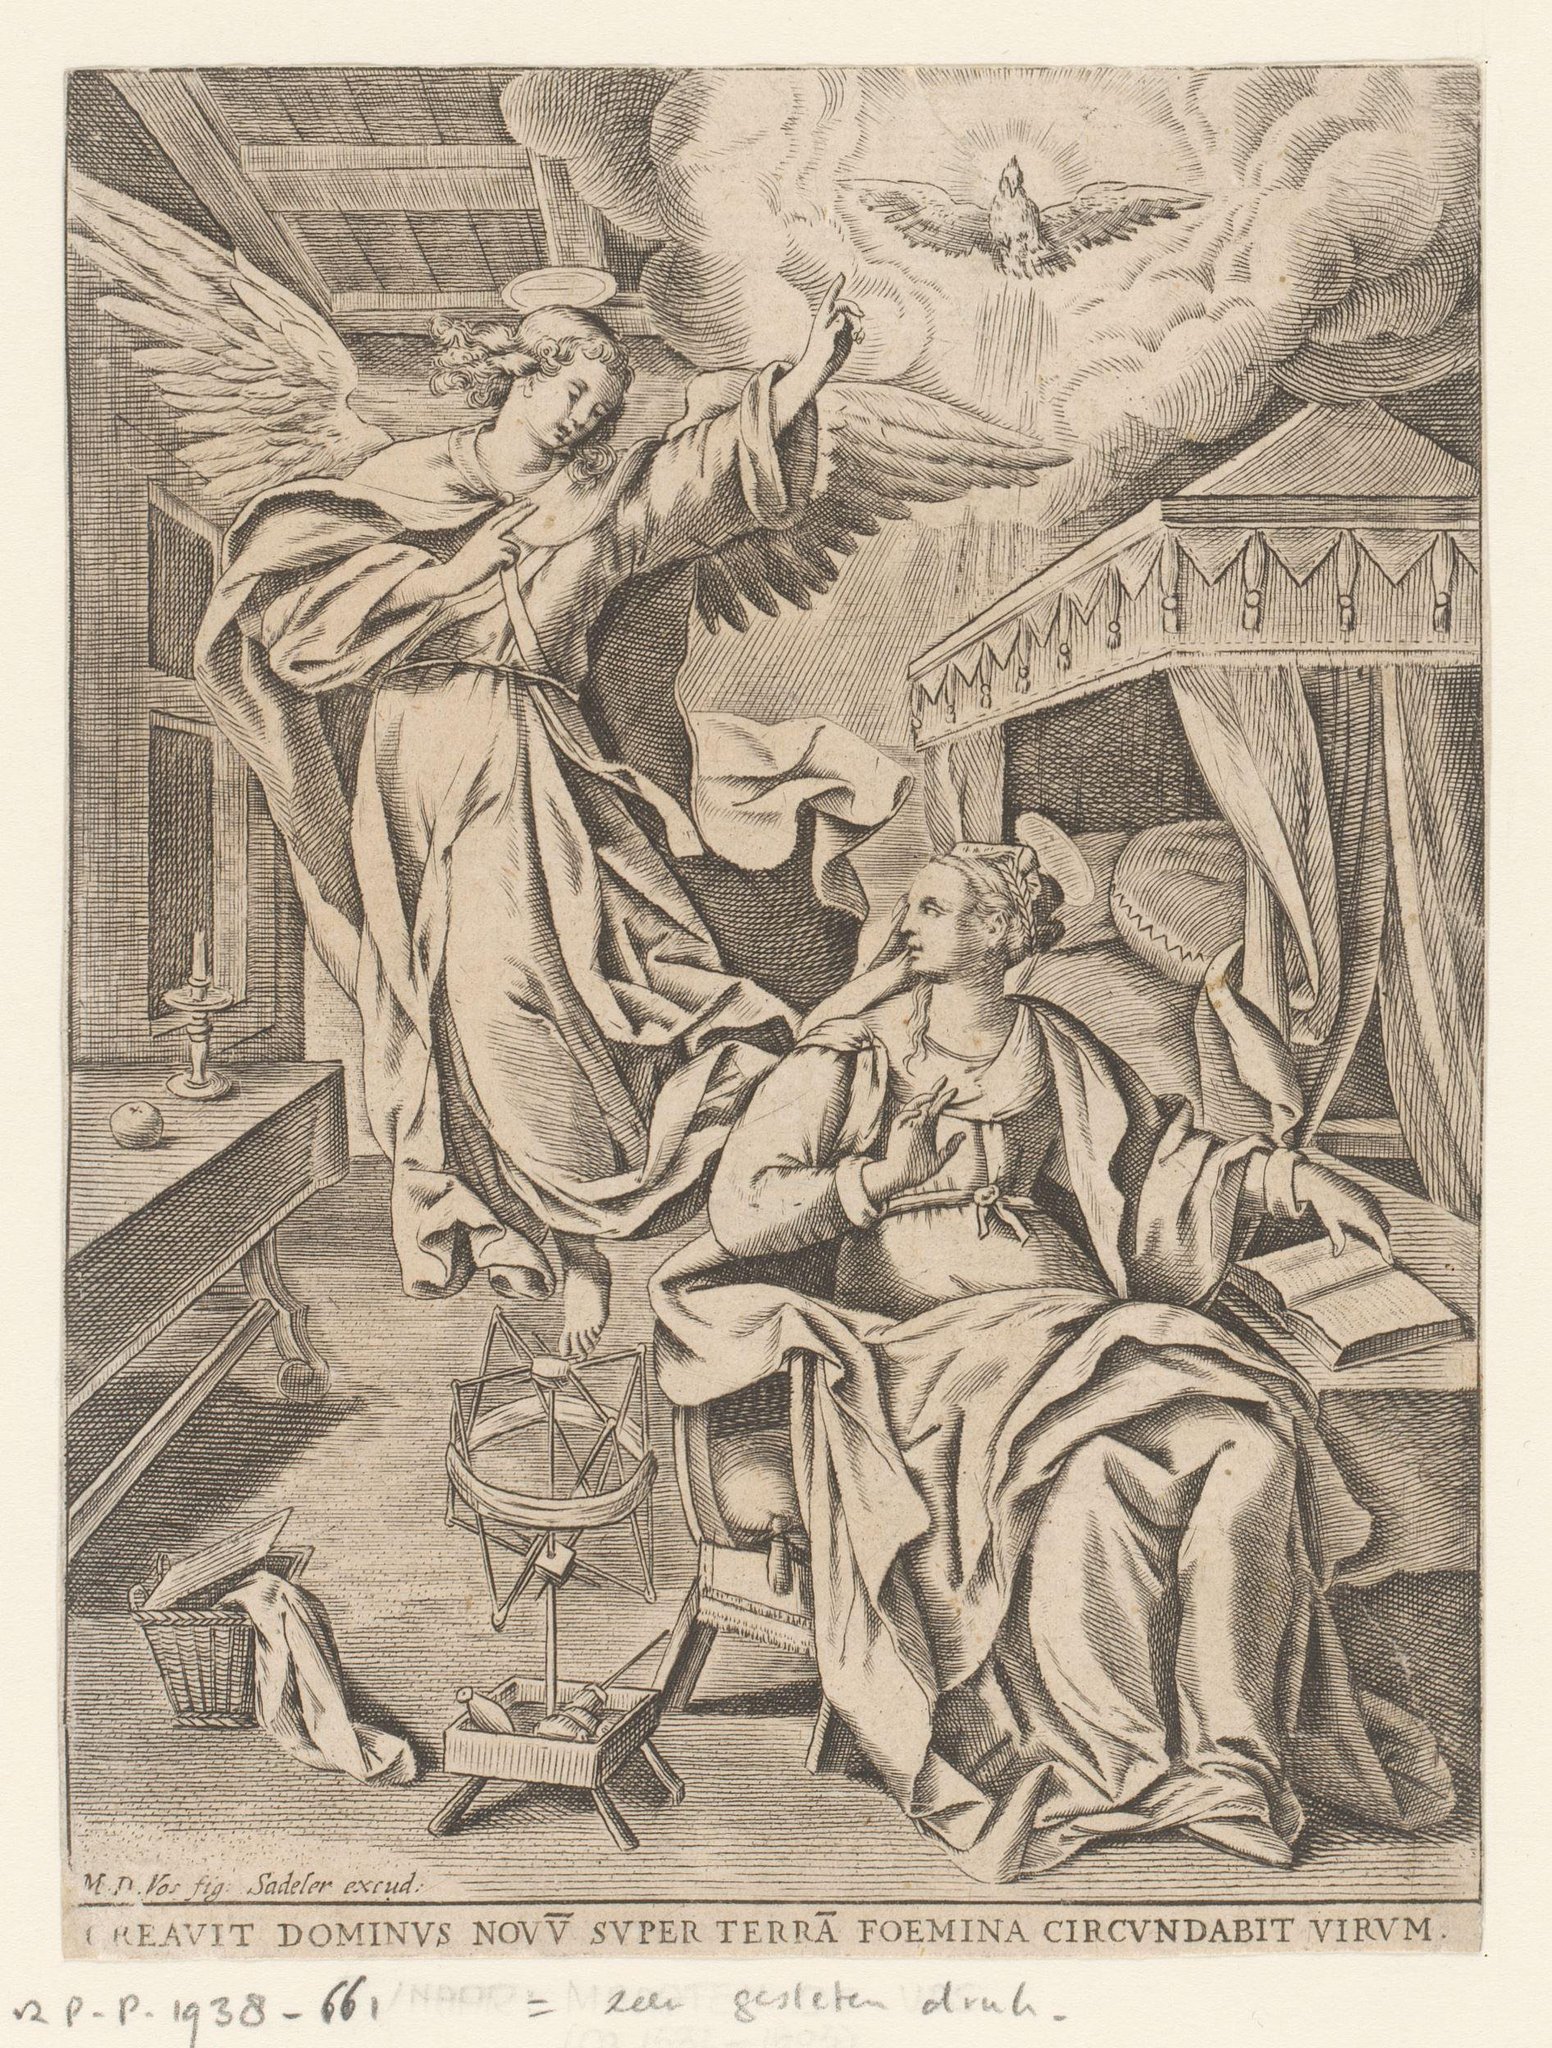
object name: print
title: Annunciatie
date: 1587-1589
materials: paper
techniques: engraving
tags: mary (alone) reading, praying, etc. ~ annunciation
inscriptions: collector's mark: Lugt 2228